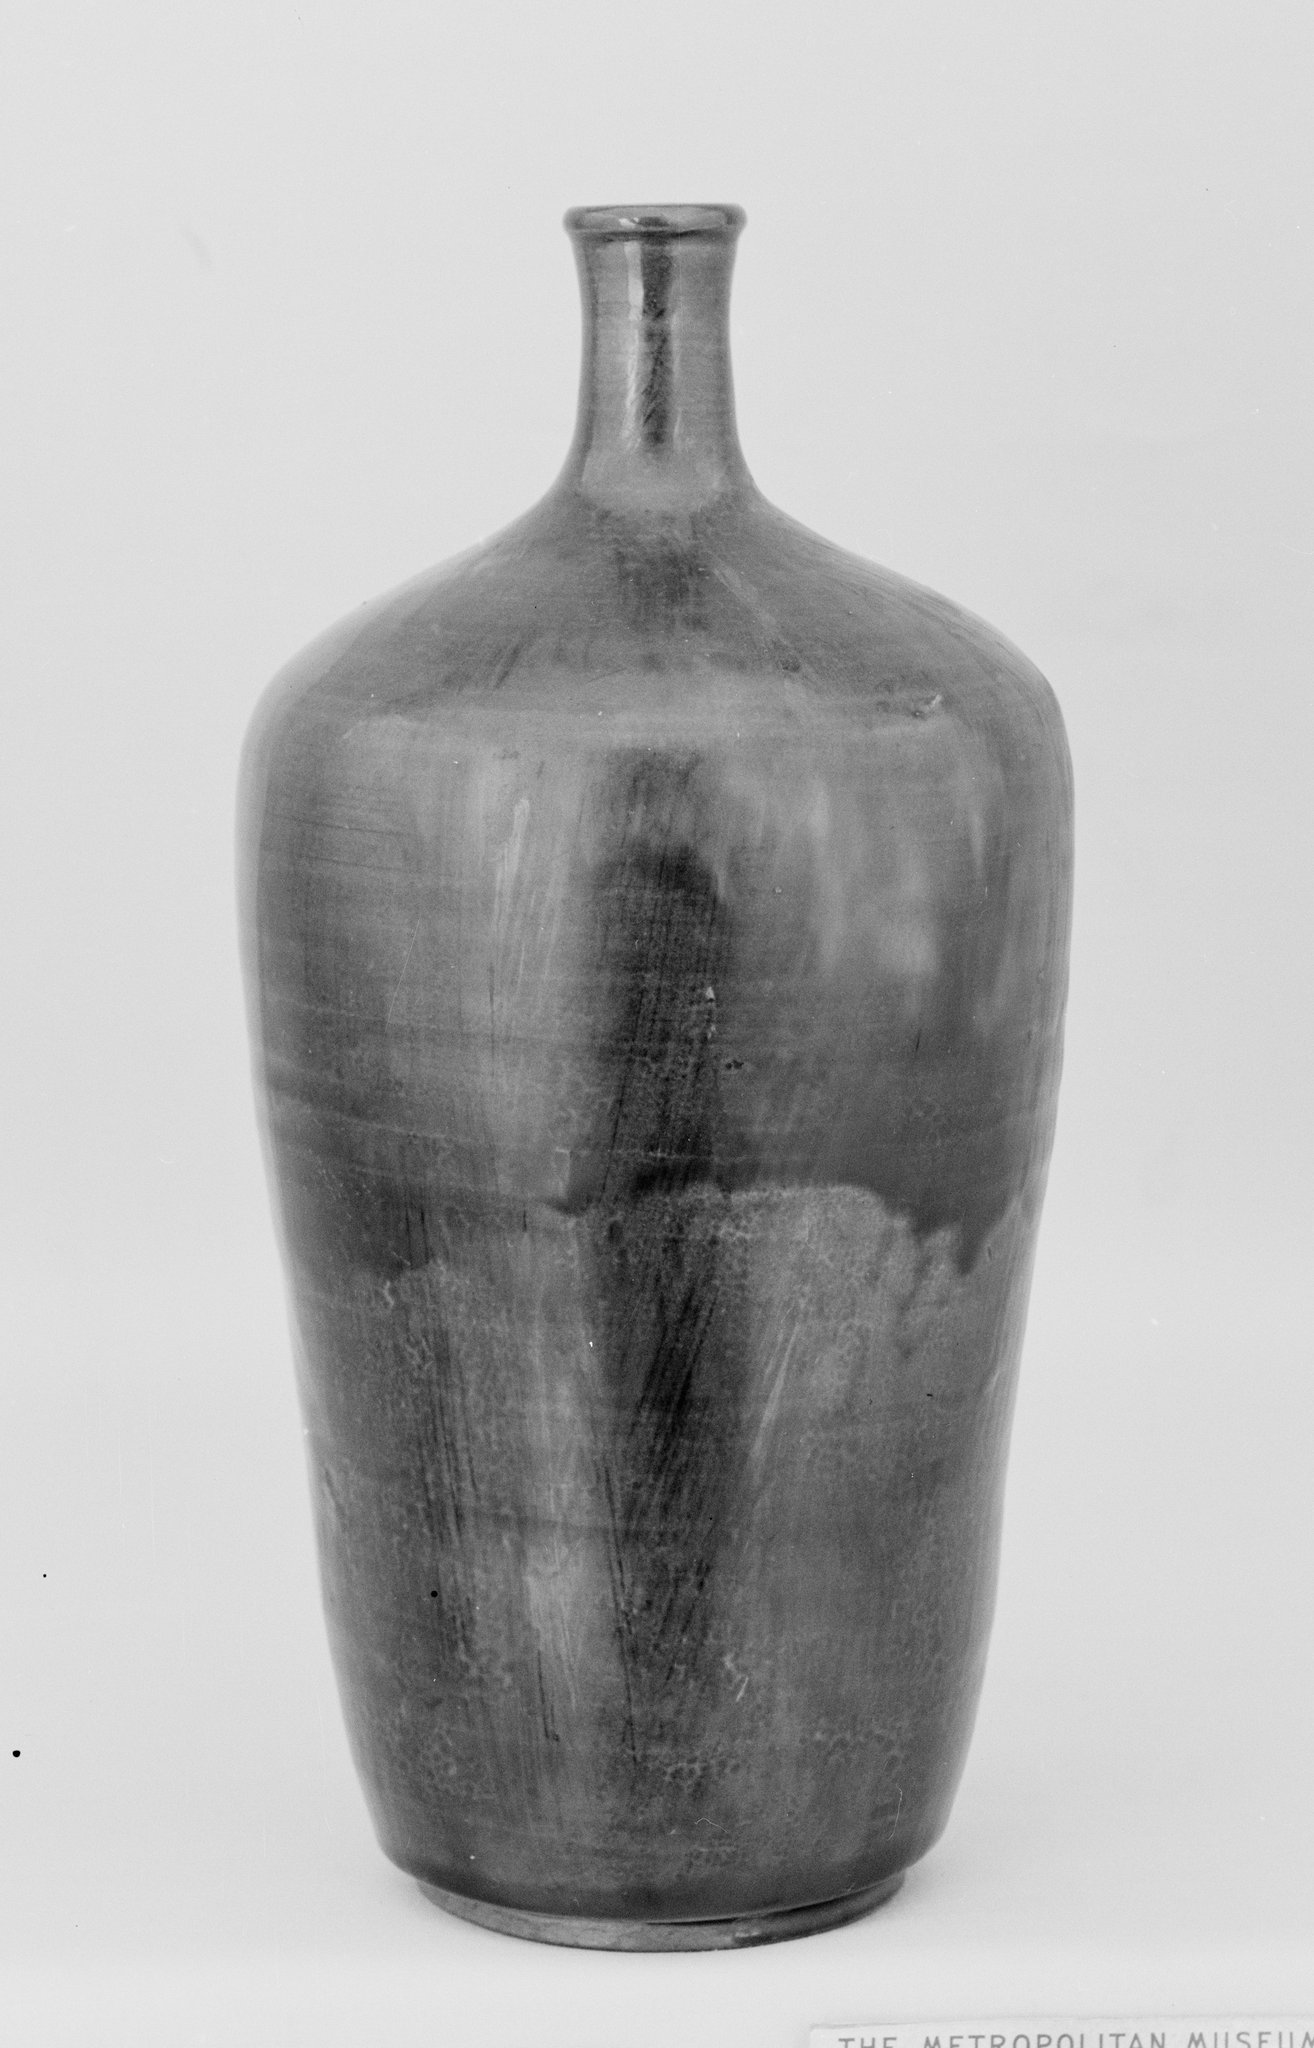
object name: bottle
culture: japanese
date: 1801-1900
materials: clay, glaze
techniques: glazing